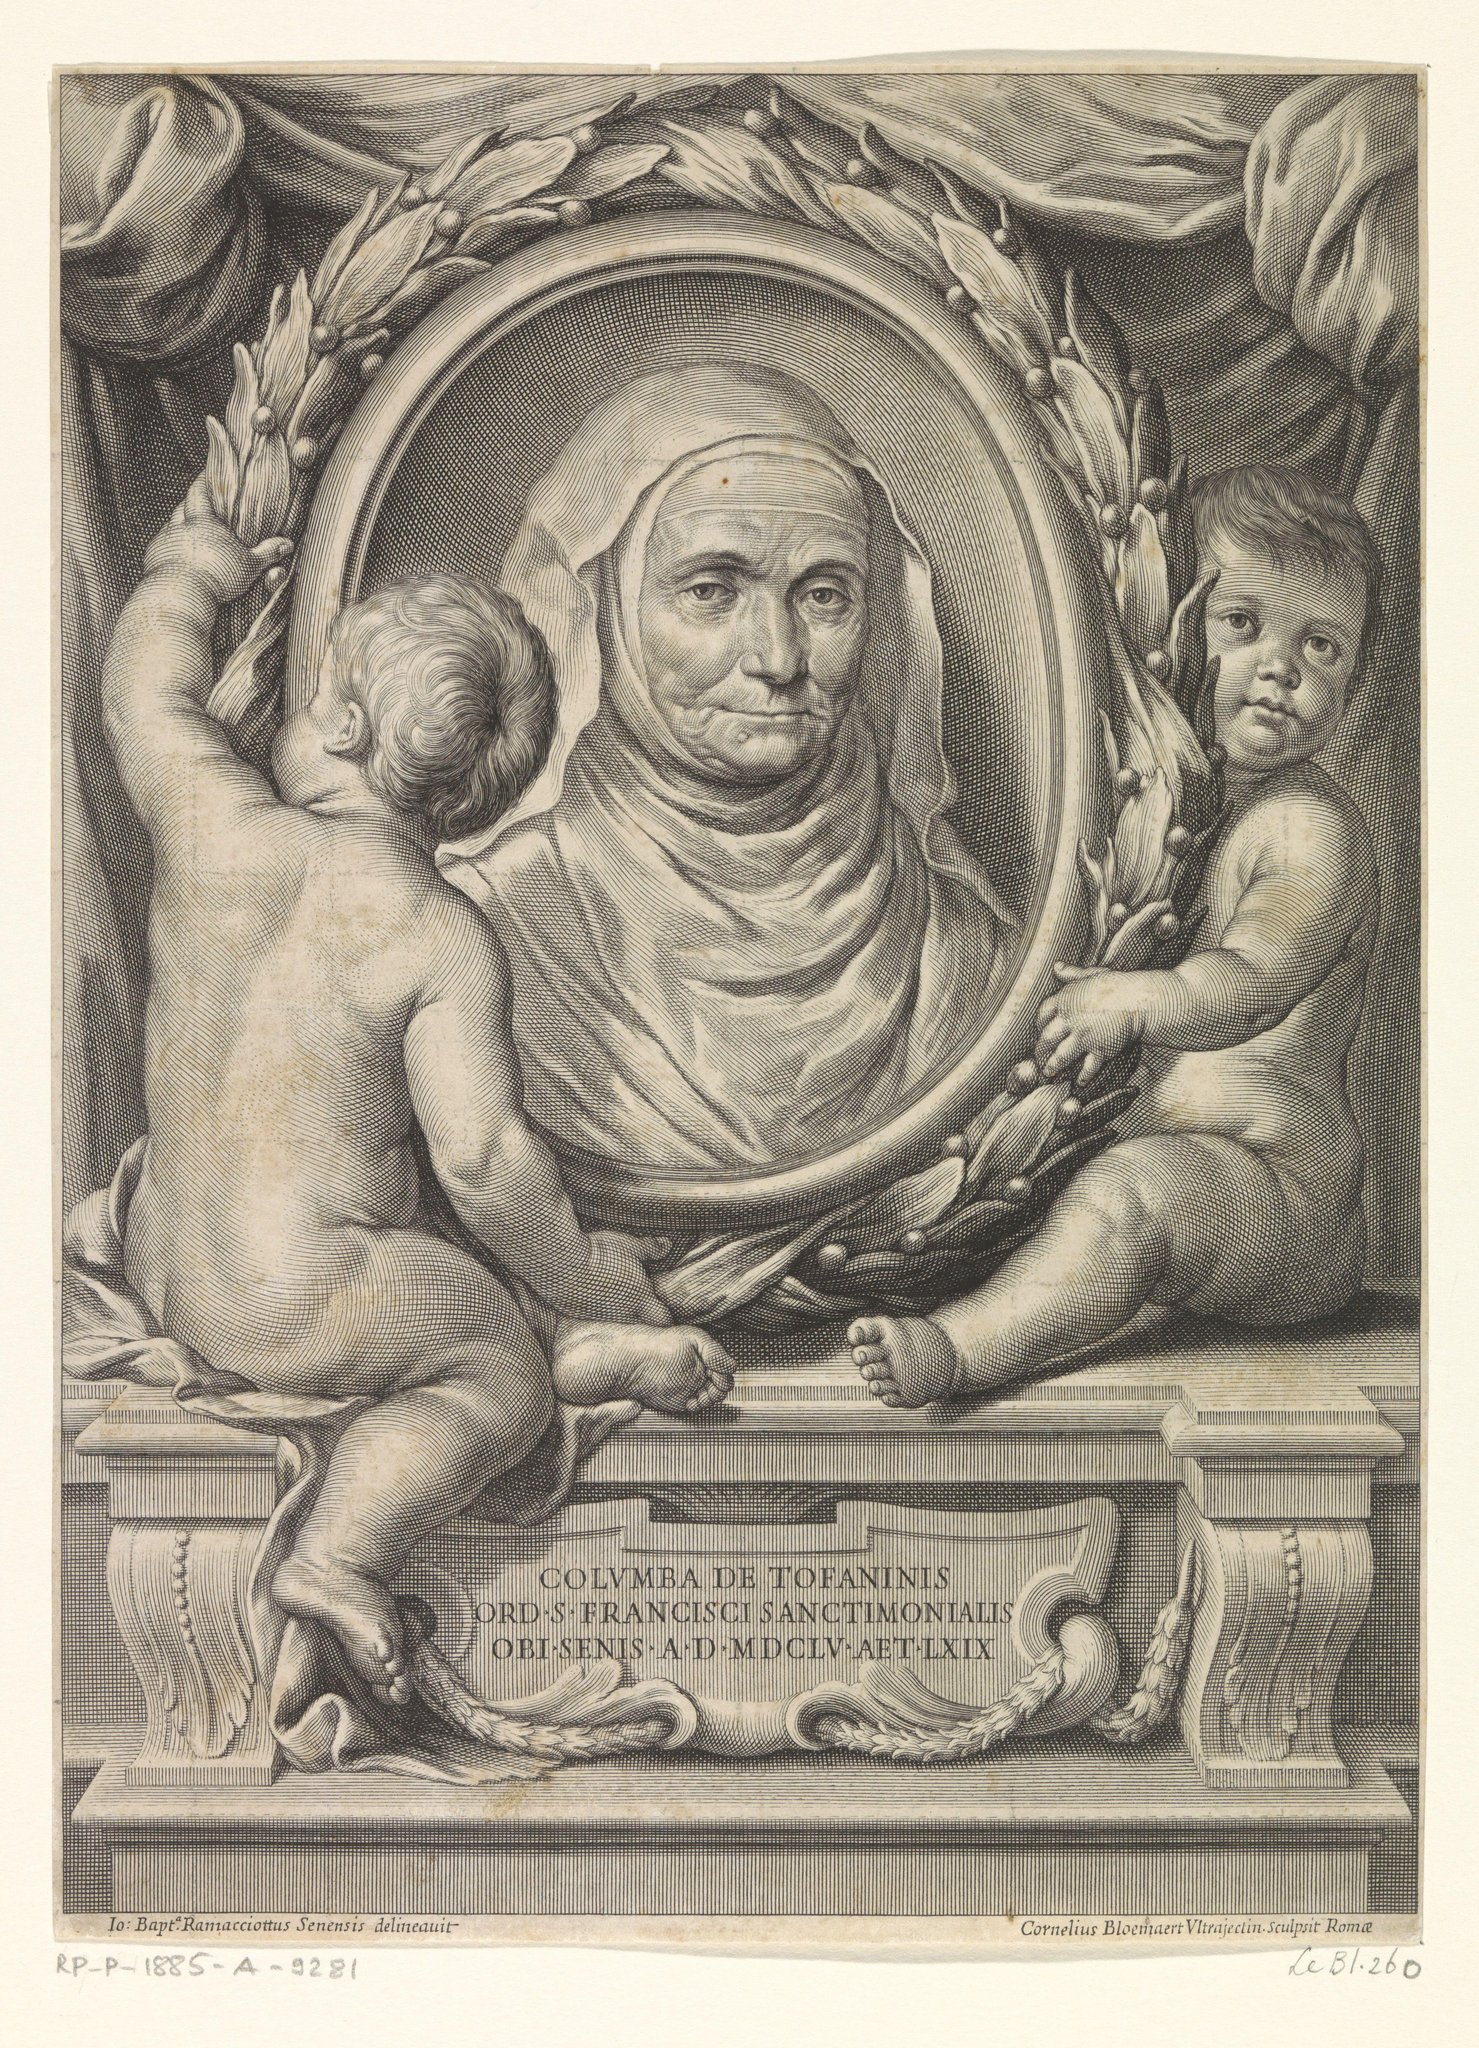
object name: print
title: Portret van Zuster Columba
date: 1655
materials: paper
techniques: engraving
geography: rome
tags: nun(s)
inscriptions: collector's mark: Lugt 2228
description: Portret van Columba de Tofaninsis, lid van de Franciscaner Orde. Borstbeeld in habijt met sluier.